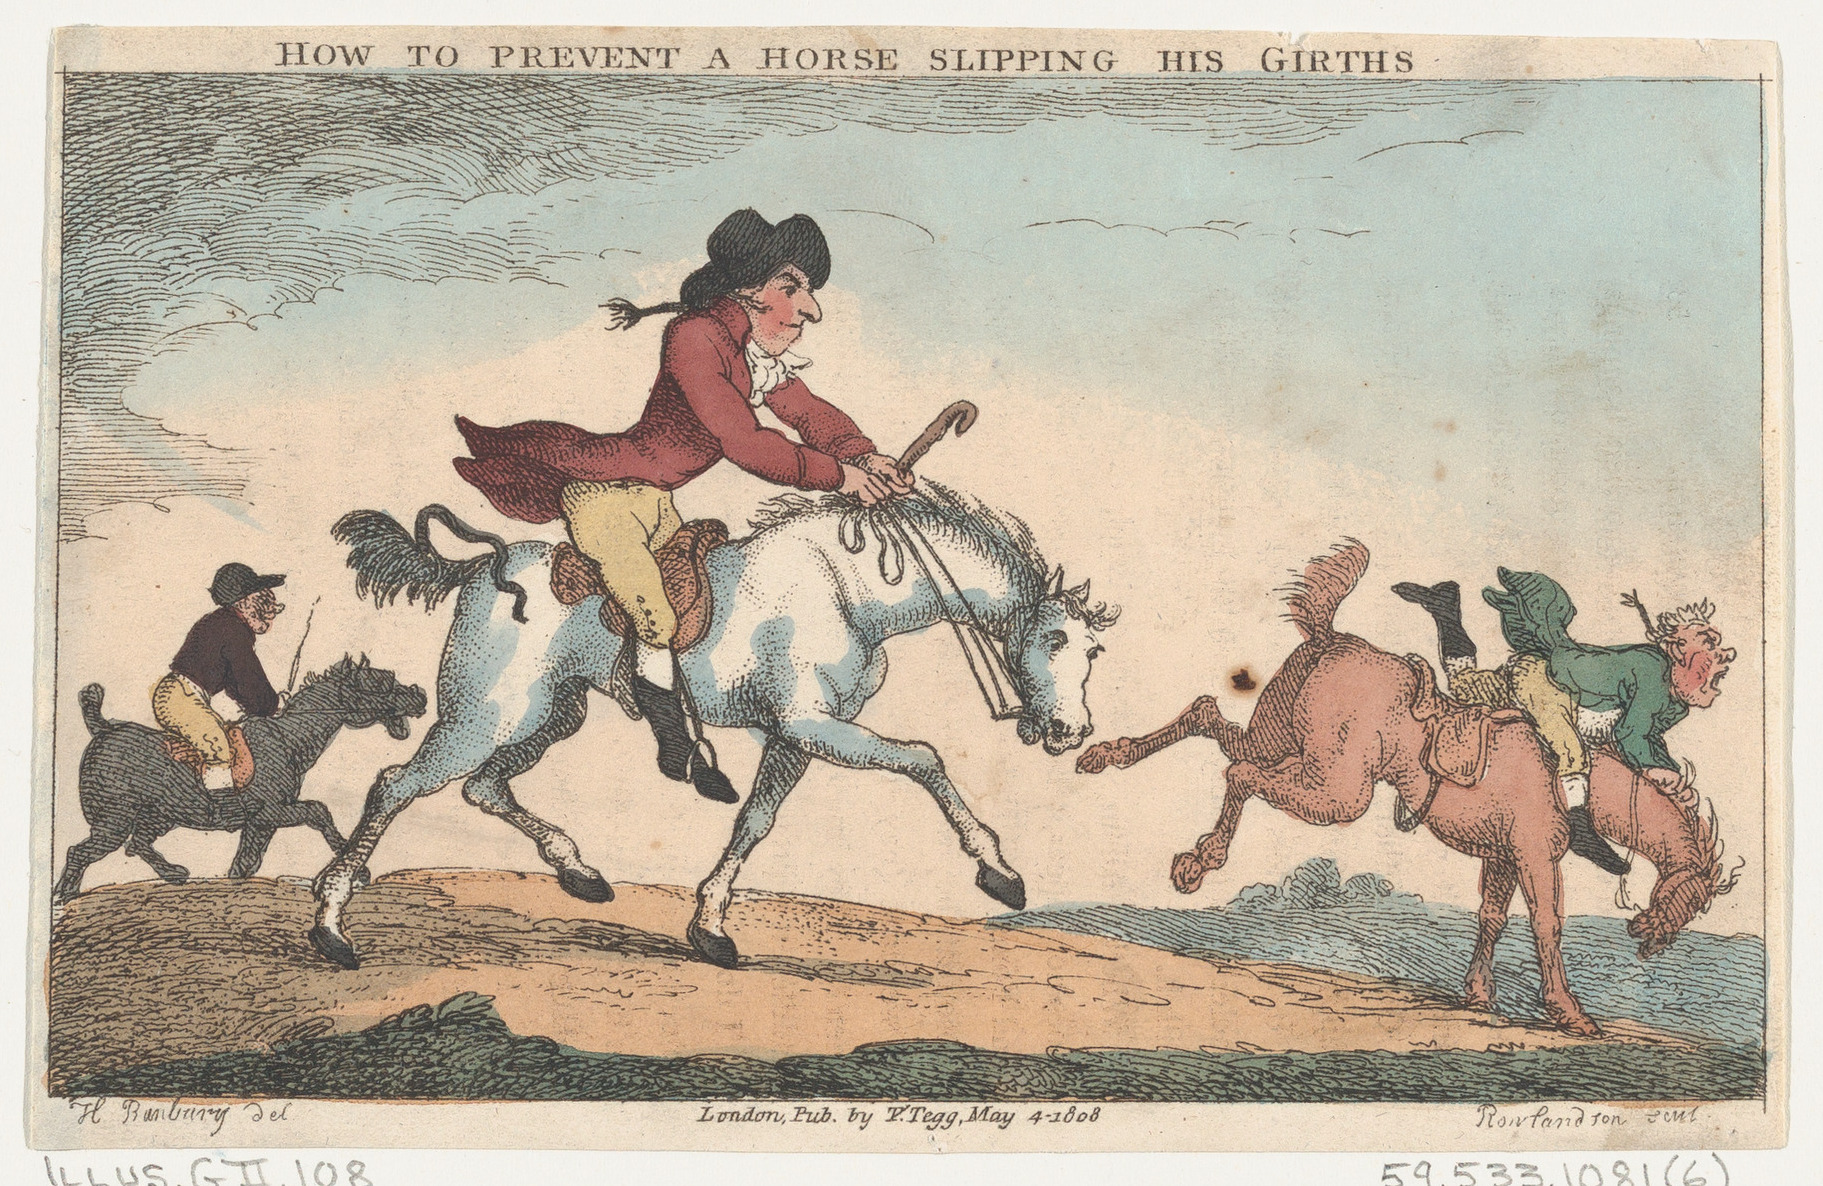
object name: print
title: How to Prevent a Horse From Slipping His Girths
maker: thomas rowlandson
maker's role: artist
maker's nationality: british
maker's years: 1757-1827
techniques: etching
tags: satire,men,horses